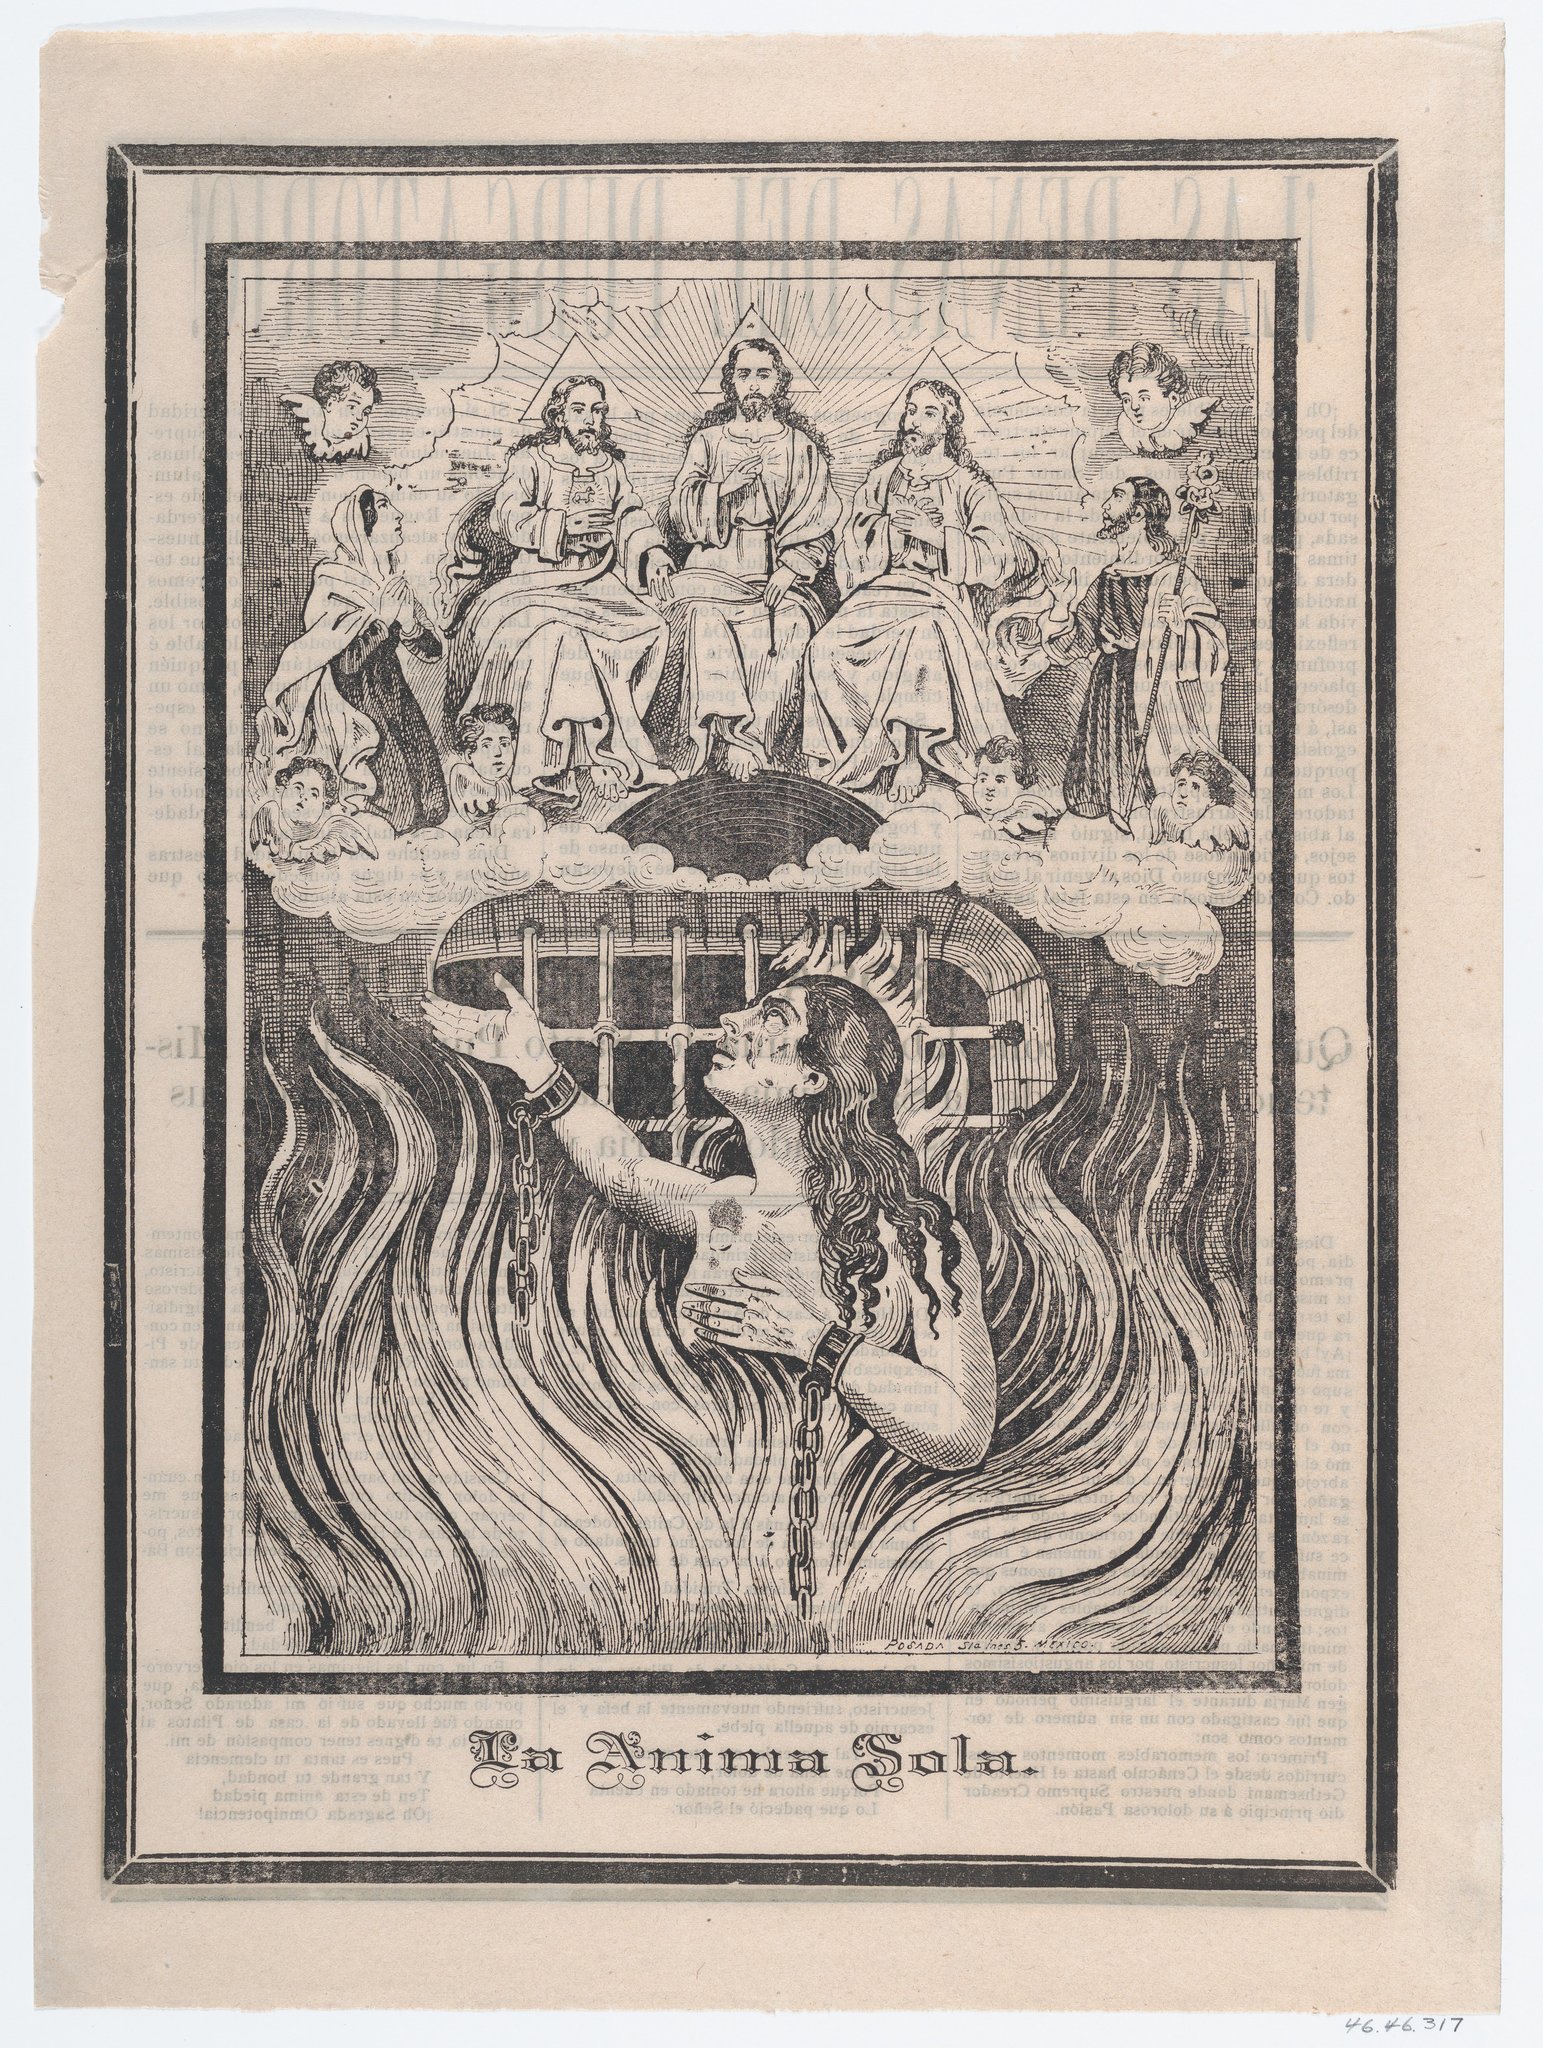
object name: print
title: Broadsheet with image of a chained woman in purgatory and the Holy Trinity above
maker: josé guadalupe posada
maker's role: artist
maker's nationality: mexican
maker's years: 1852-1913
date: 1900-1910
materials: paper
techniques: letterpress, lithography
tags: suffering,women,fire,jesus